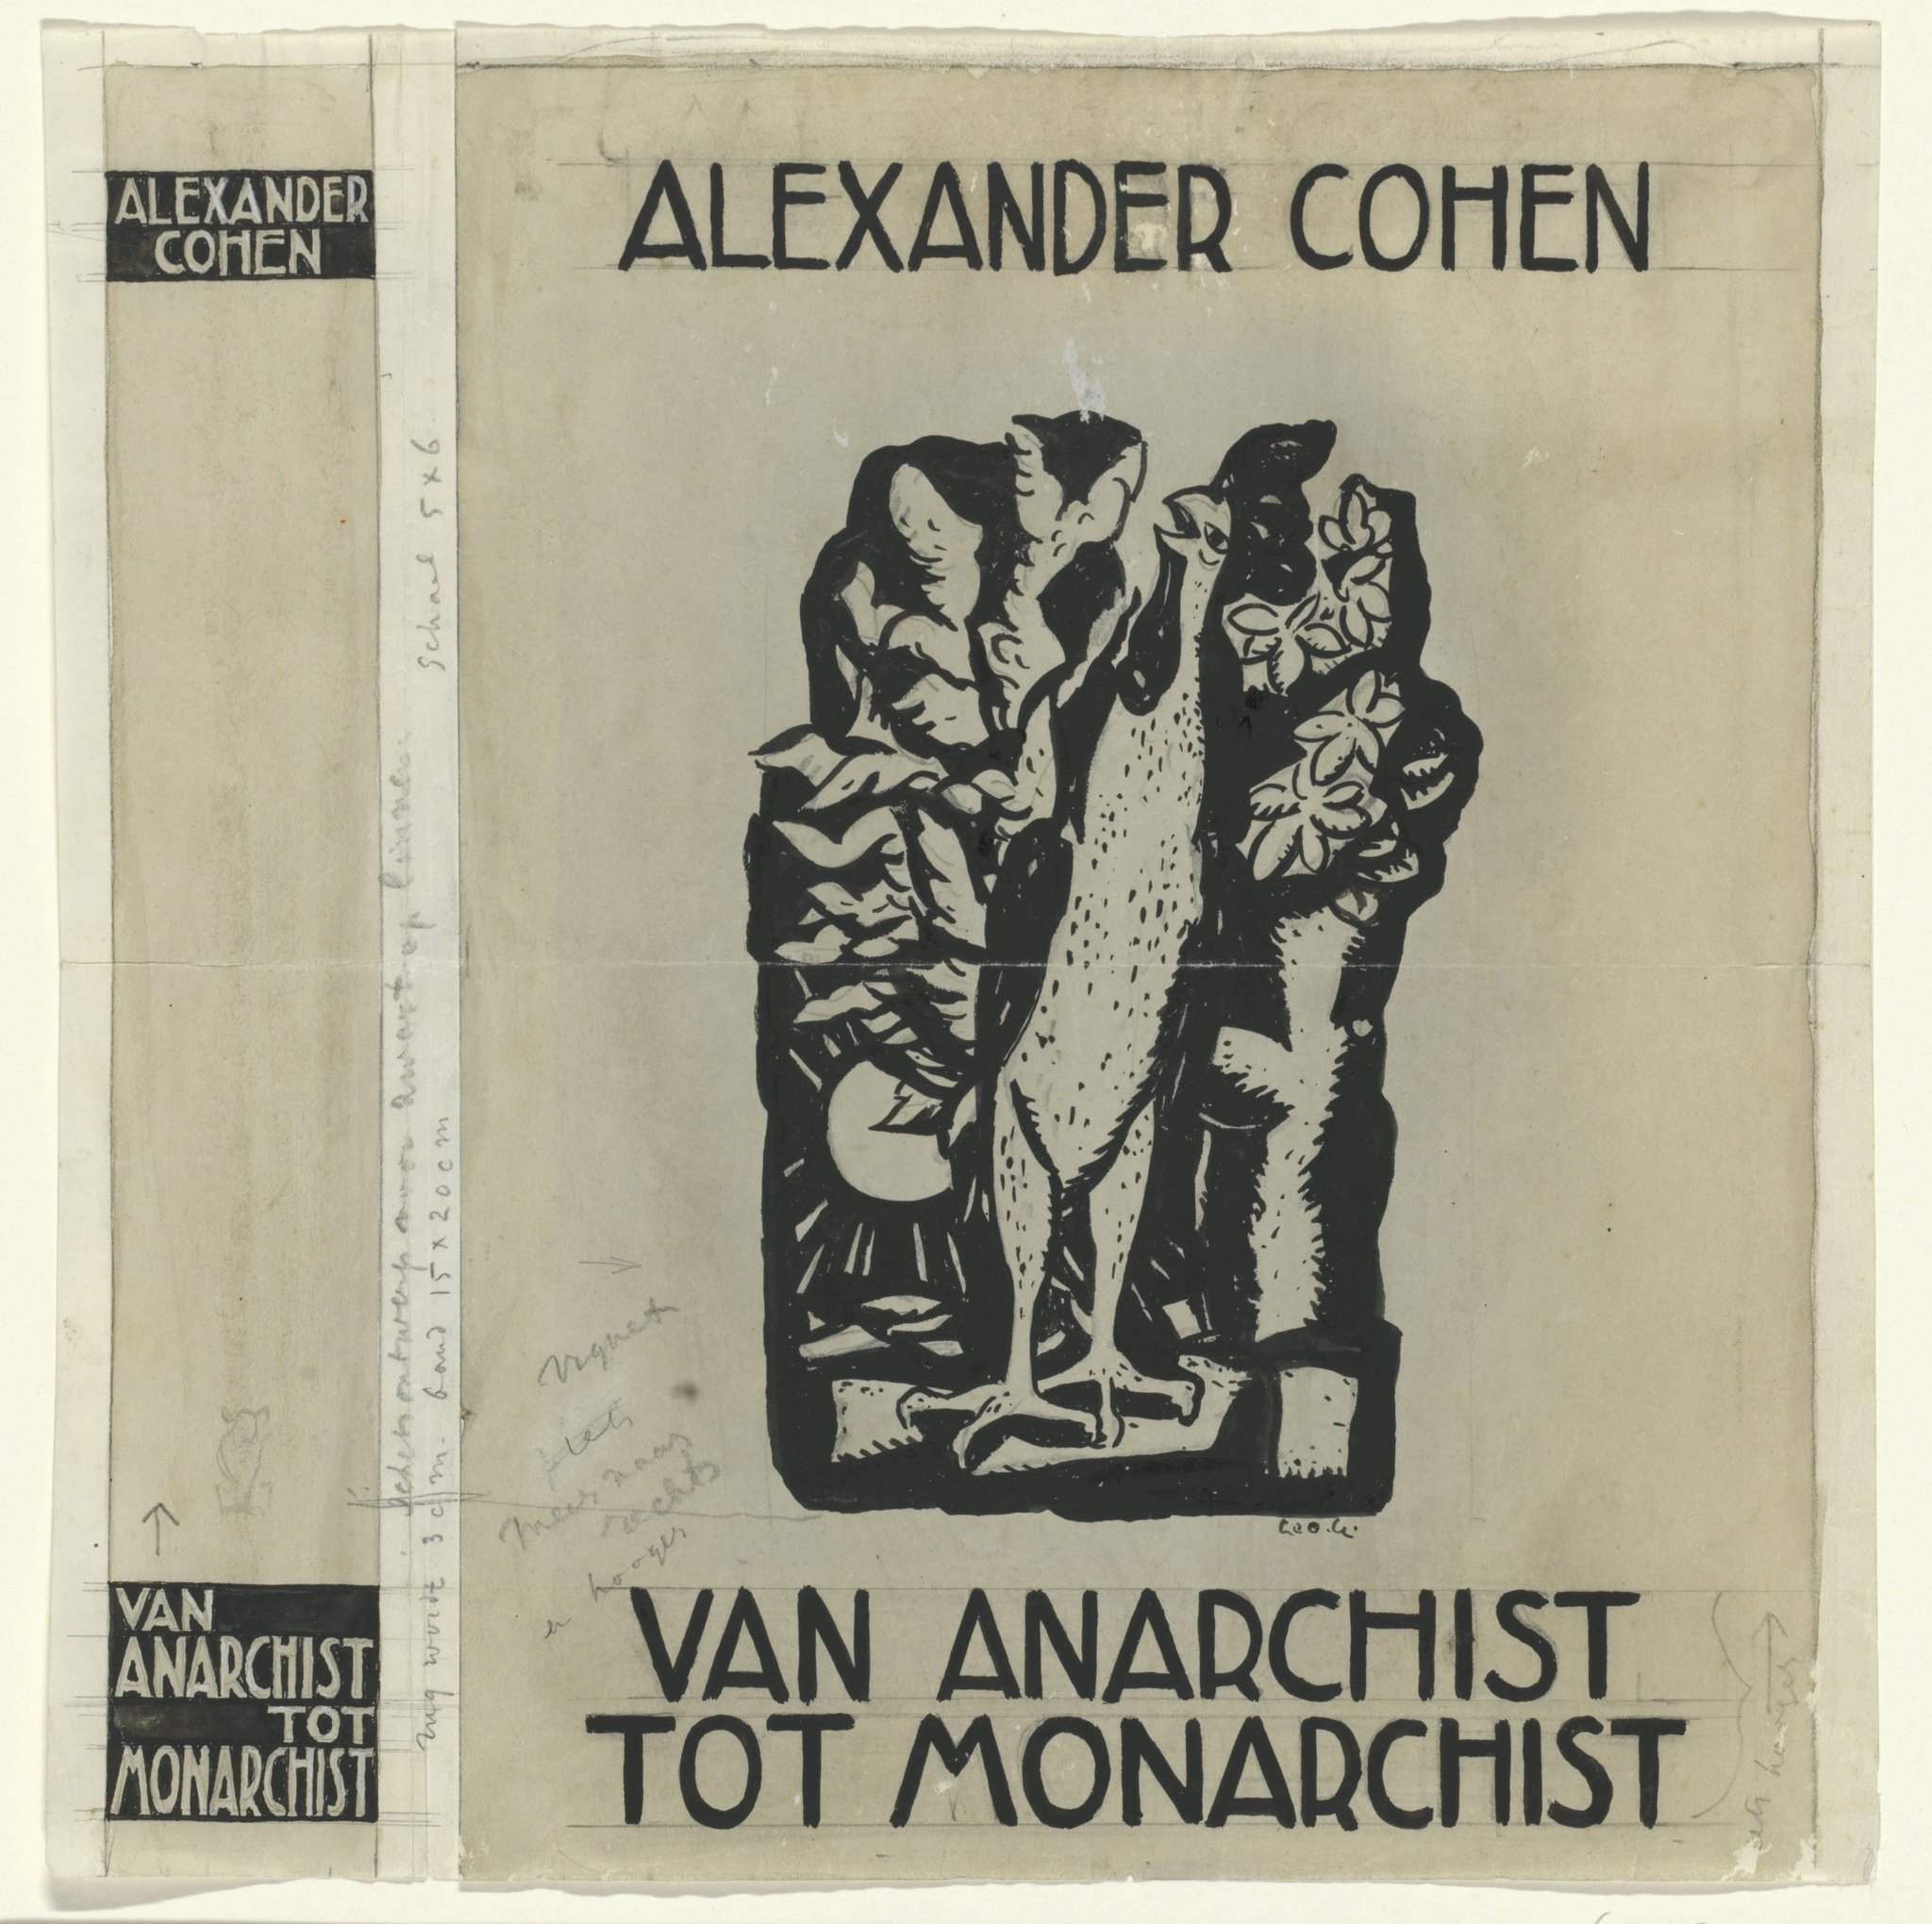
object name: study for binding design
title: Ontwerp voor band en rug van: Alexander Cohen, Van anarchist tot monarchist, 1936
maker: leo gestel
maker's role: draughtsman, print maker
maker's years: 1881-1941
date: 1934-1936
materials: ink, pencil, paper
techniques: brush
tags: book-cover, binding, fowl (cock, hen, chicken, etc.) (+ male animal)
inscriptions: collector's mark: Lugt 2228